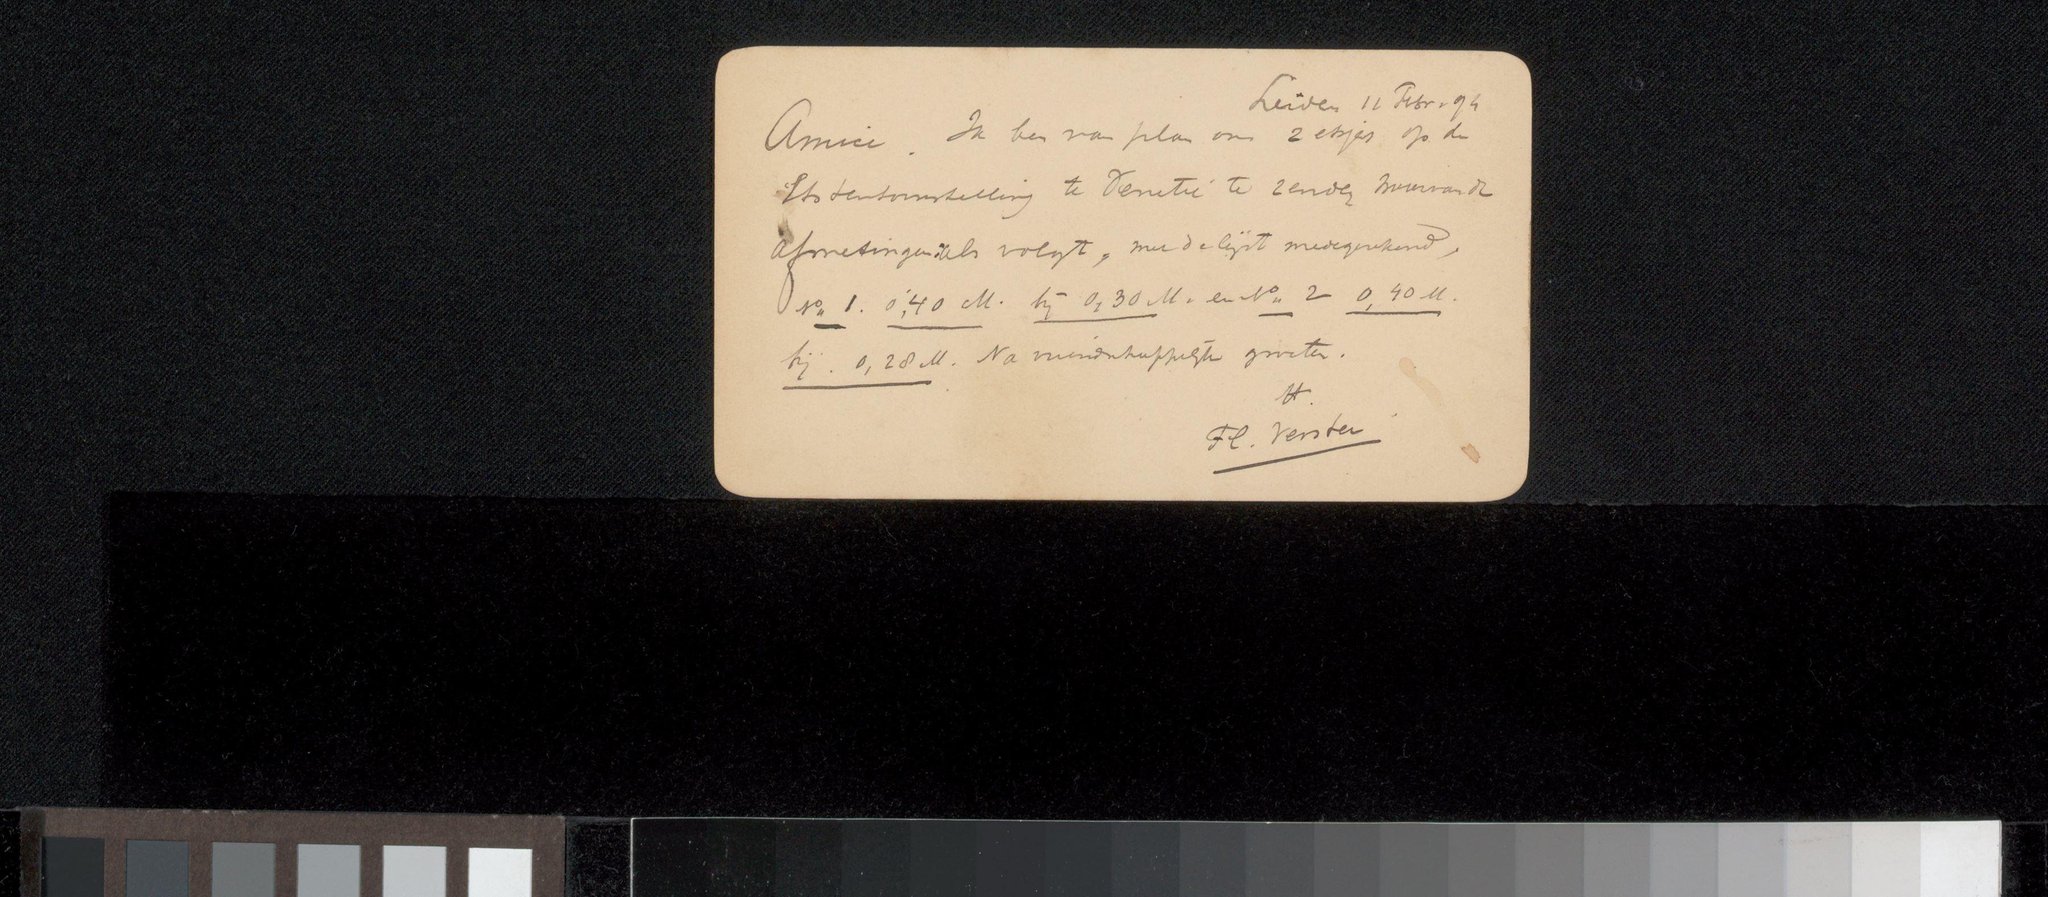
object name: letter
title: Brief aan Philip Zilcken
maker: floris verster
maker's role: draughtsman, painter, print maker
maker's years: 1861-1927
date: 1894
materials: cardboard, ink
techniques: pen, writing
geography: leiden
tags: the hague, painter, philip zilcken, the graphic arts, exhibition ~ art, venice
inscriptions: collector's mark: ‘RPK’